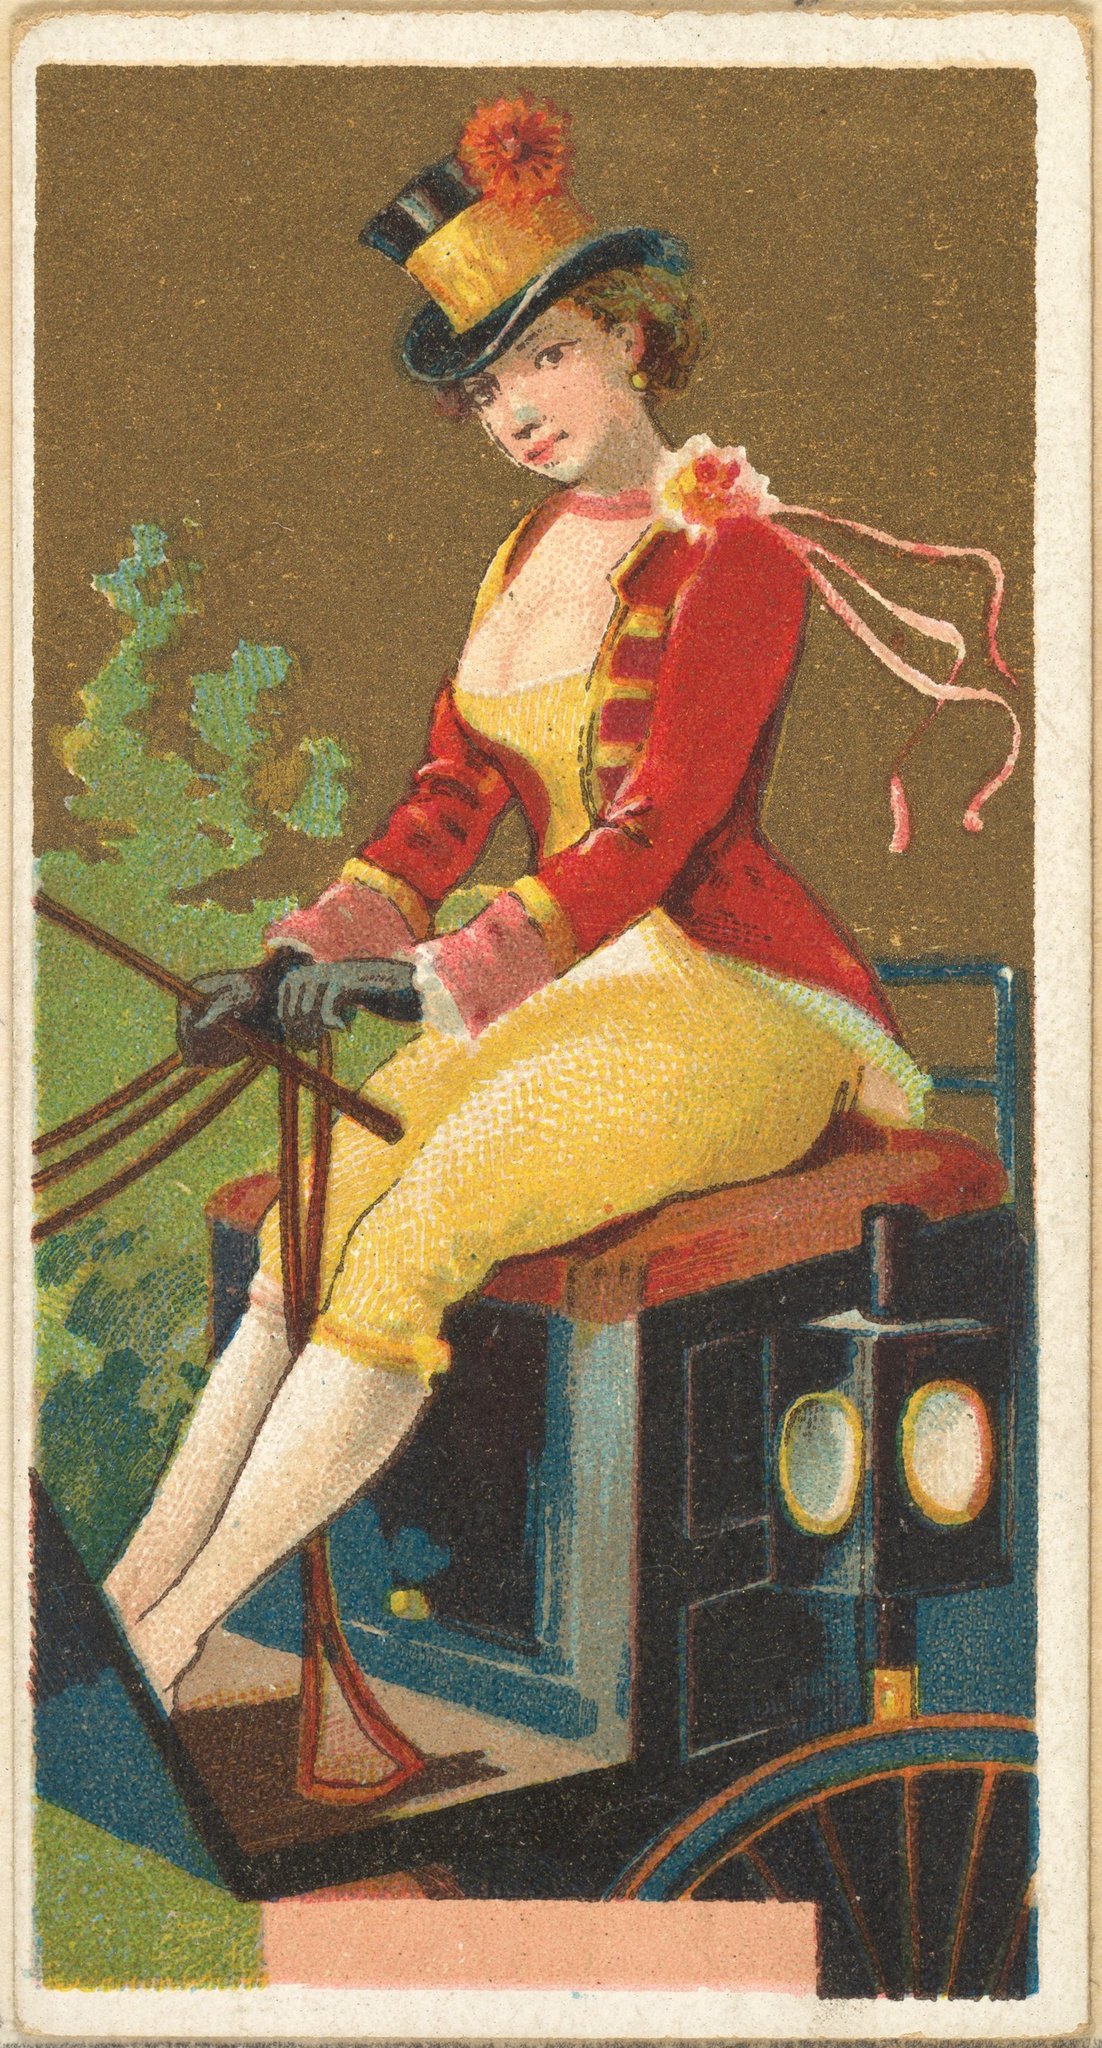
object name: print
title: Coachman, from the Occupations for Women series (N166) for Old Judge and Dogs Head Cigarettes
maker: goodwin & company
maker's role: publisher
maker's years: 1850-1950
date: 1887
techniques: color lithograph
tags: women